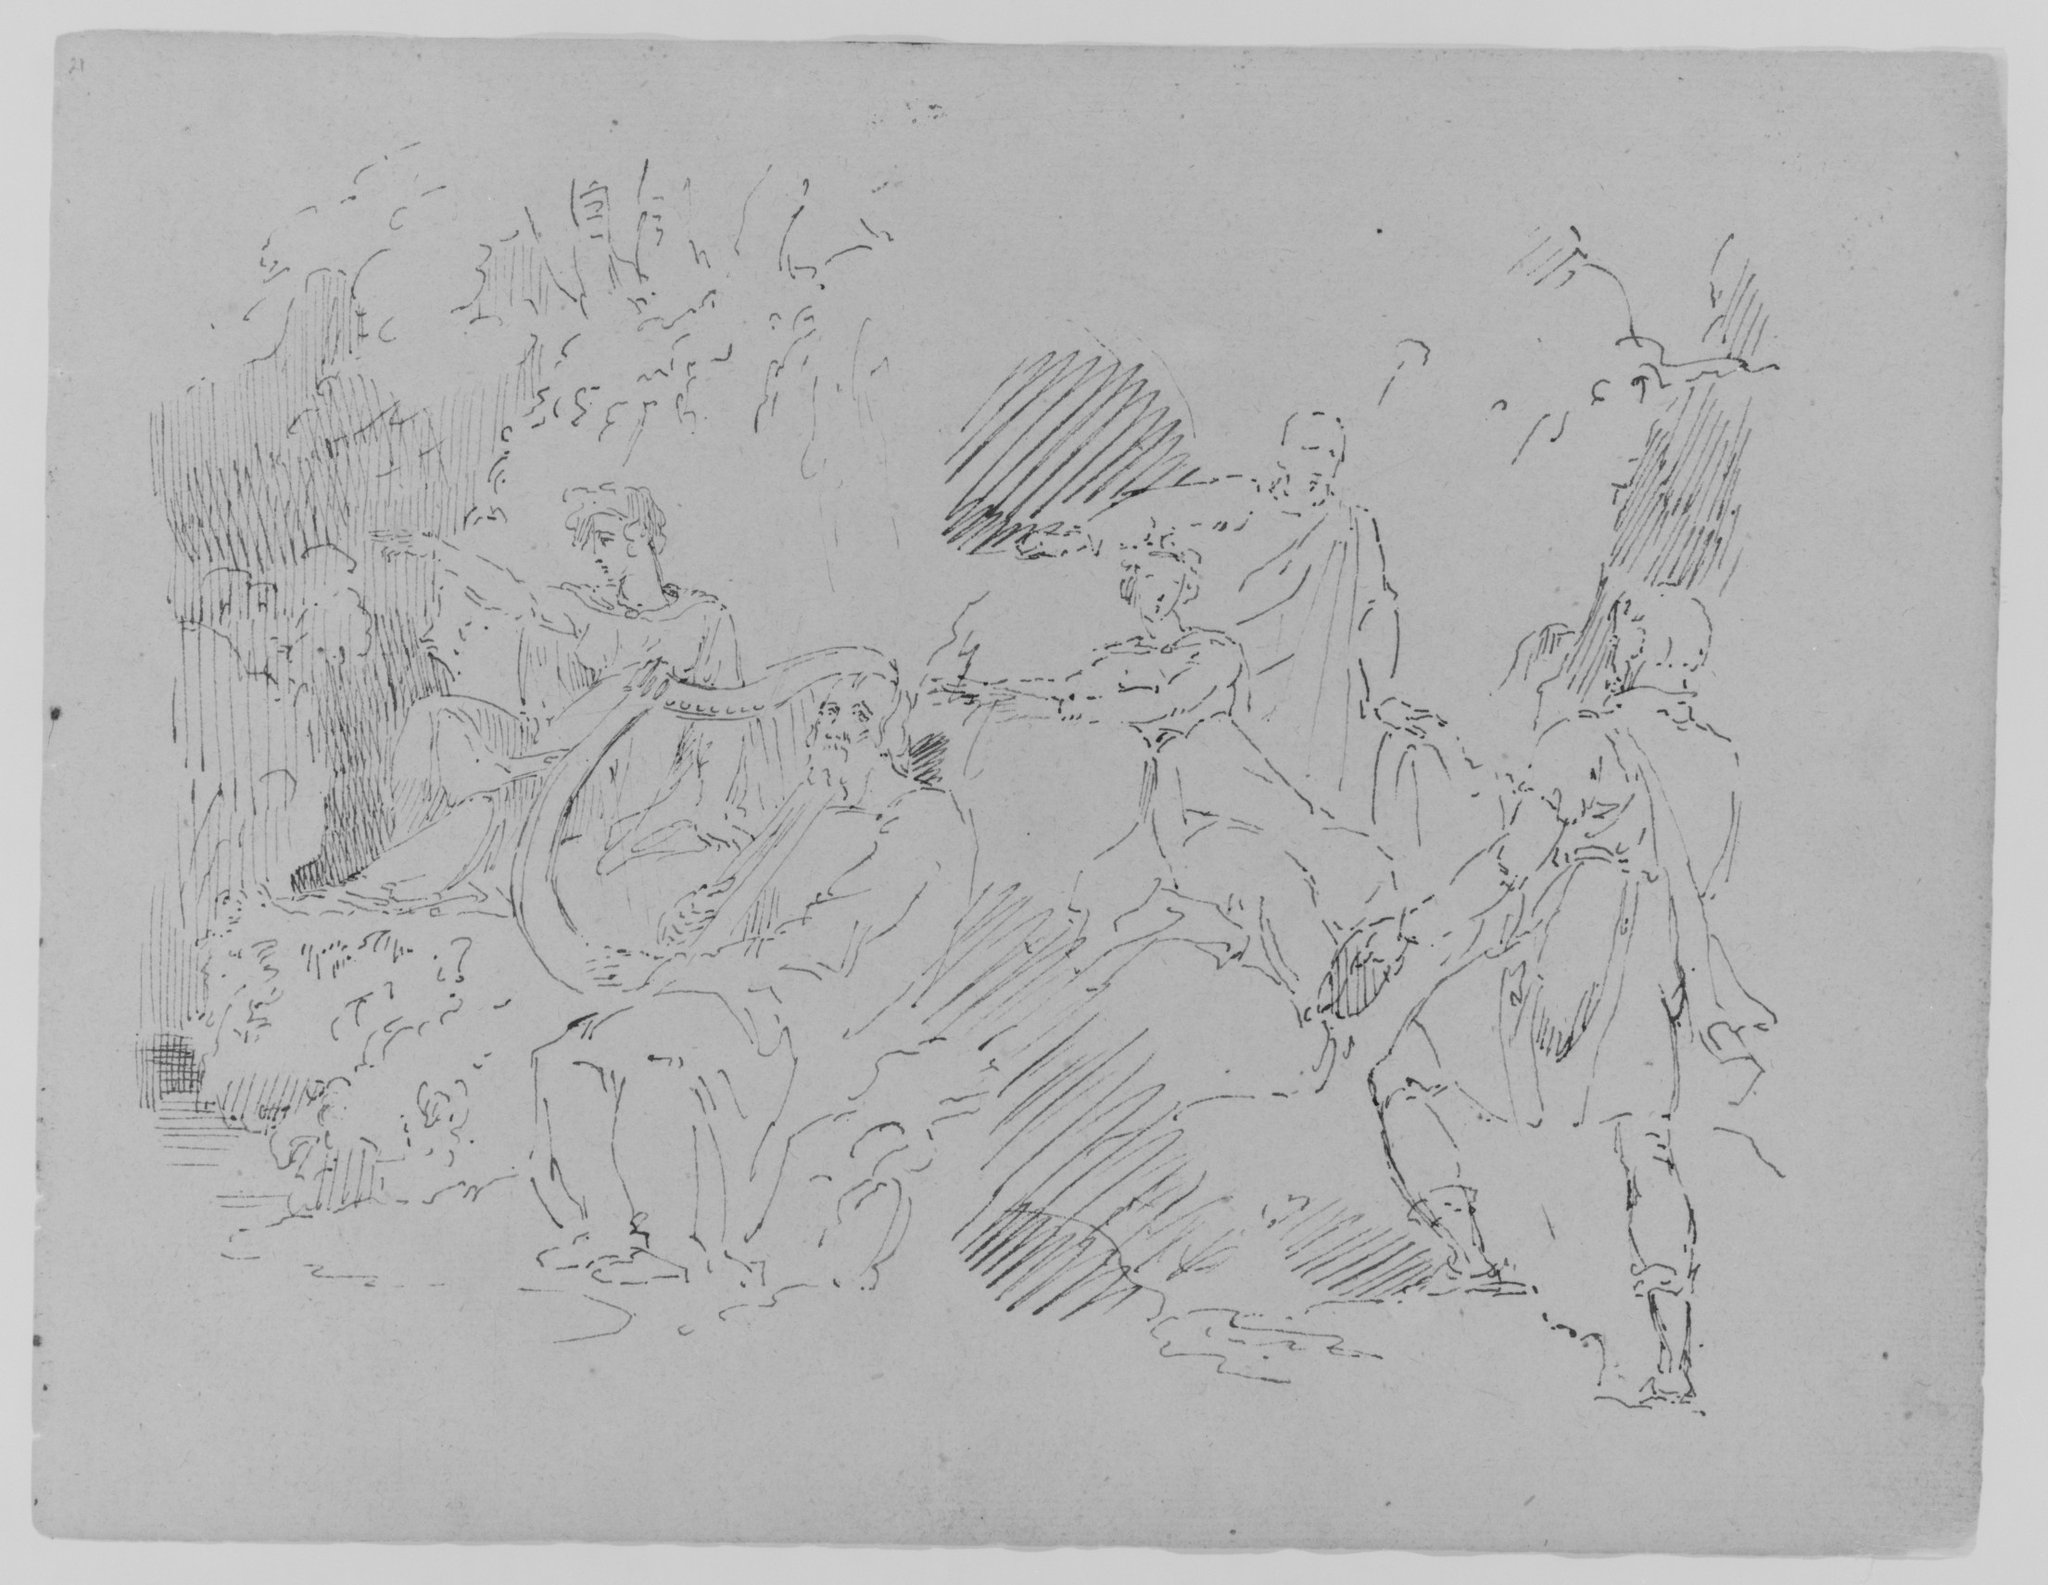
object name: drawing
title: Composition with Five Figures in Natural Setting, Two Male, Three Female, with a Lyre (Ponnassus?) (from Sketchbook)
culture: american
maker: thomas sully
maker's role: artist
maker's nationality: american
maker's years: 1783-1872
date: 1810-1820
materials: ink, paper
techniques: wash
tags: men,women